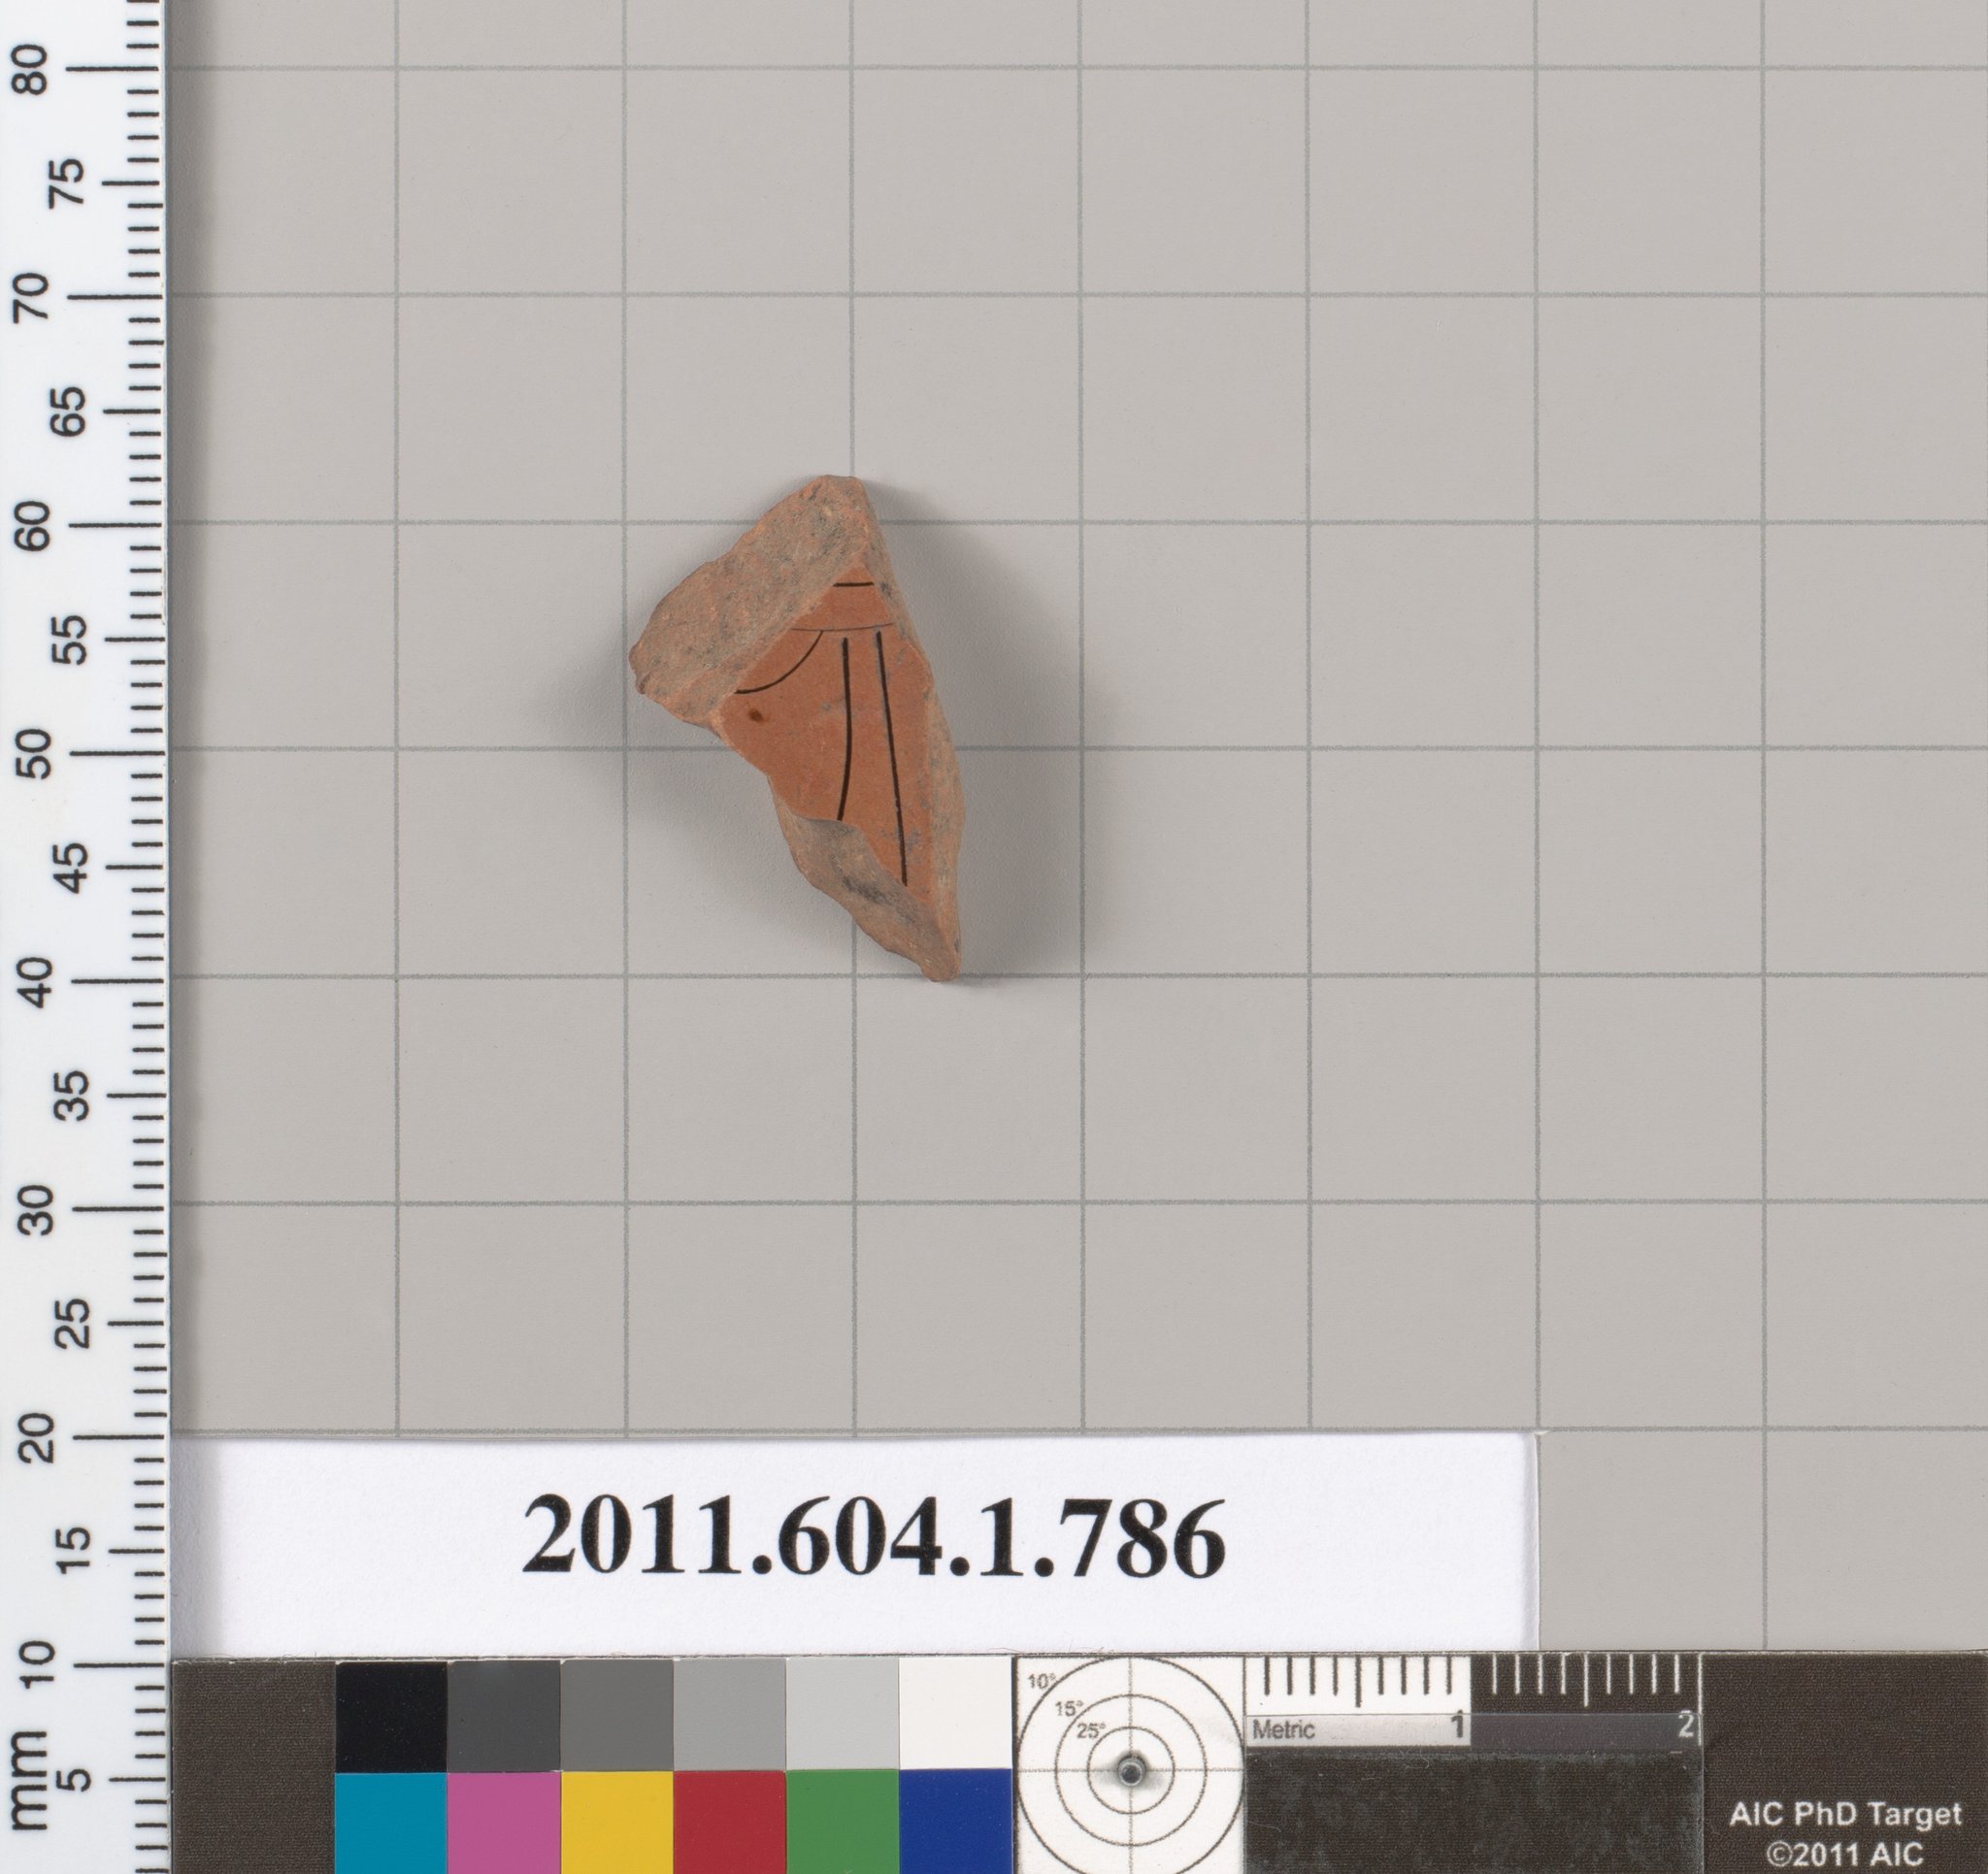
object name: kylix fragment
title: Terracotta fragment of a kylix (drinking cup)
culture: greek, attic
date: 475-451 BCE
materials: terracotta